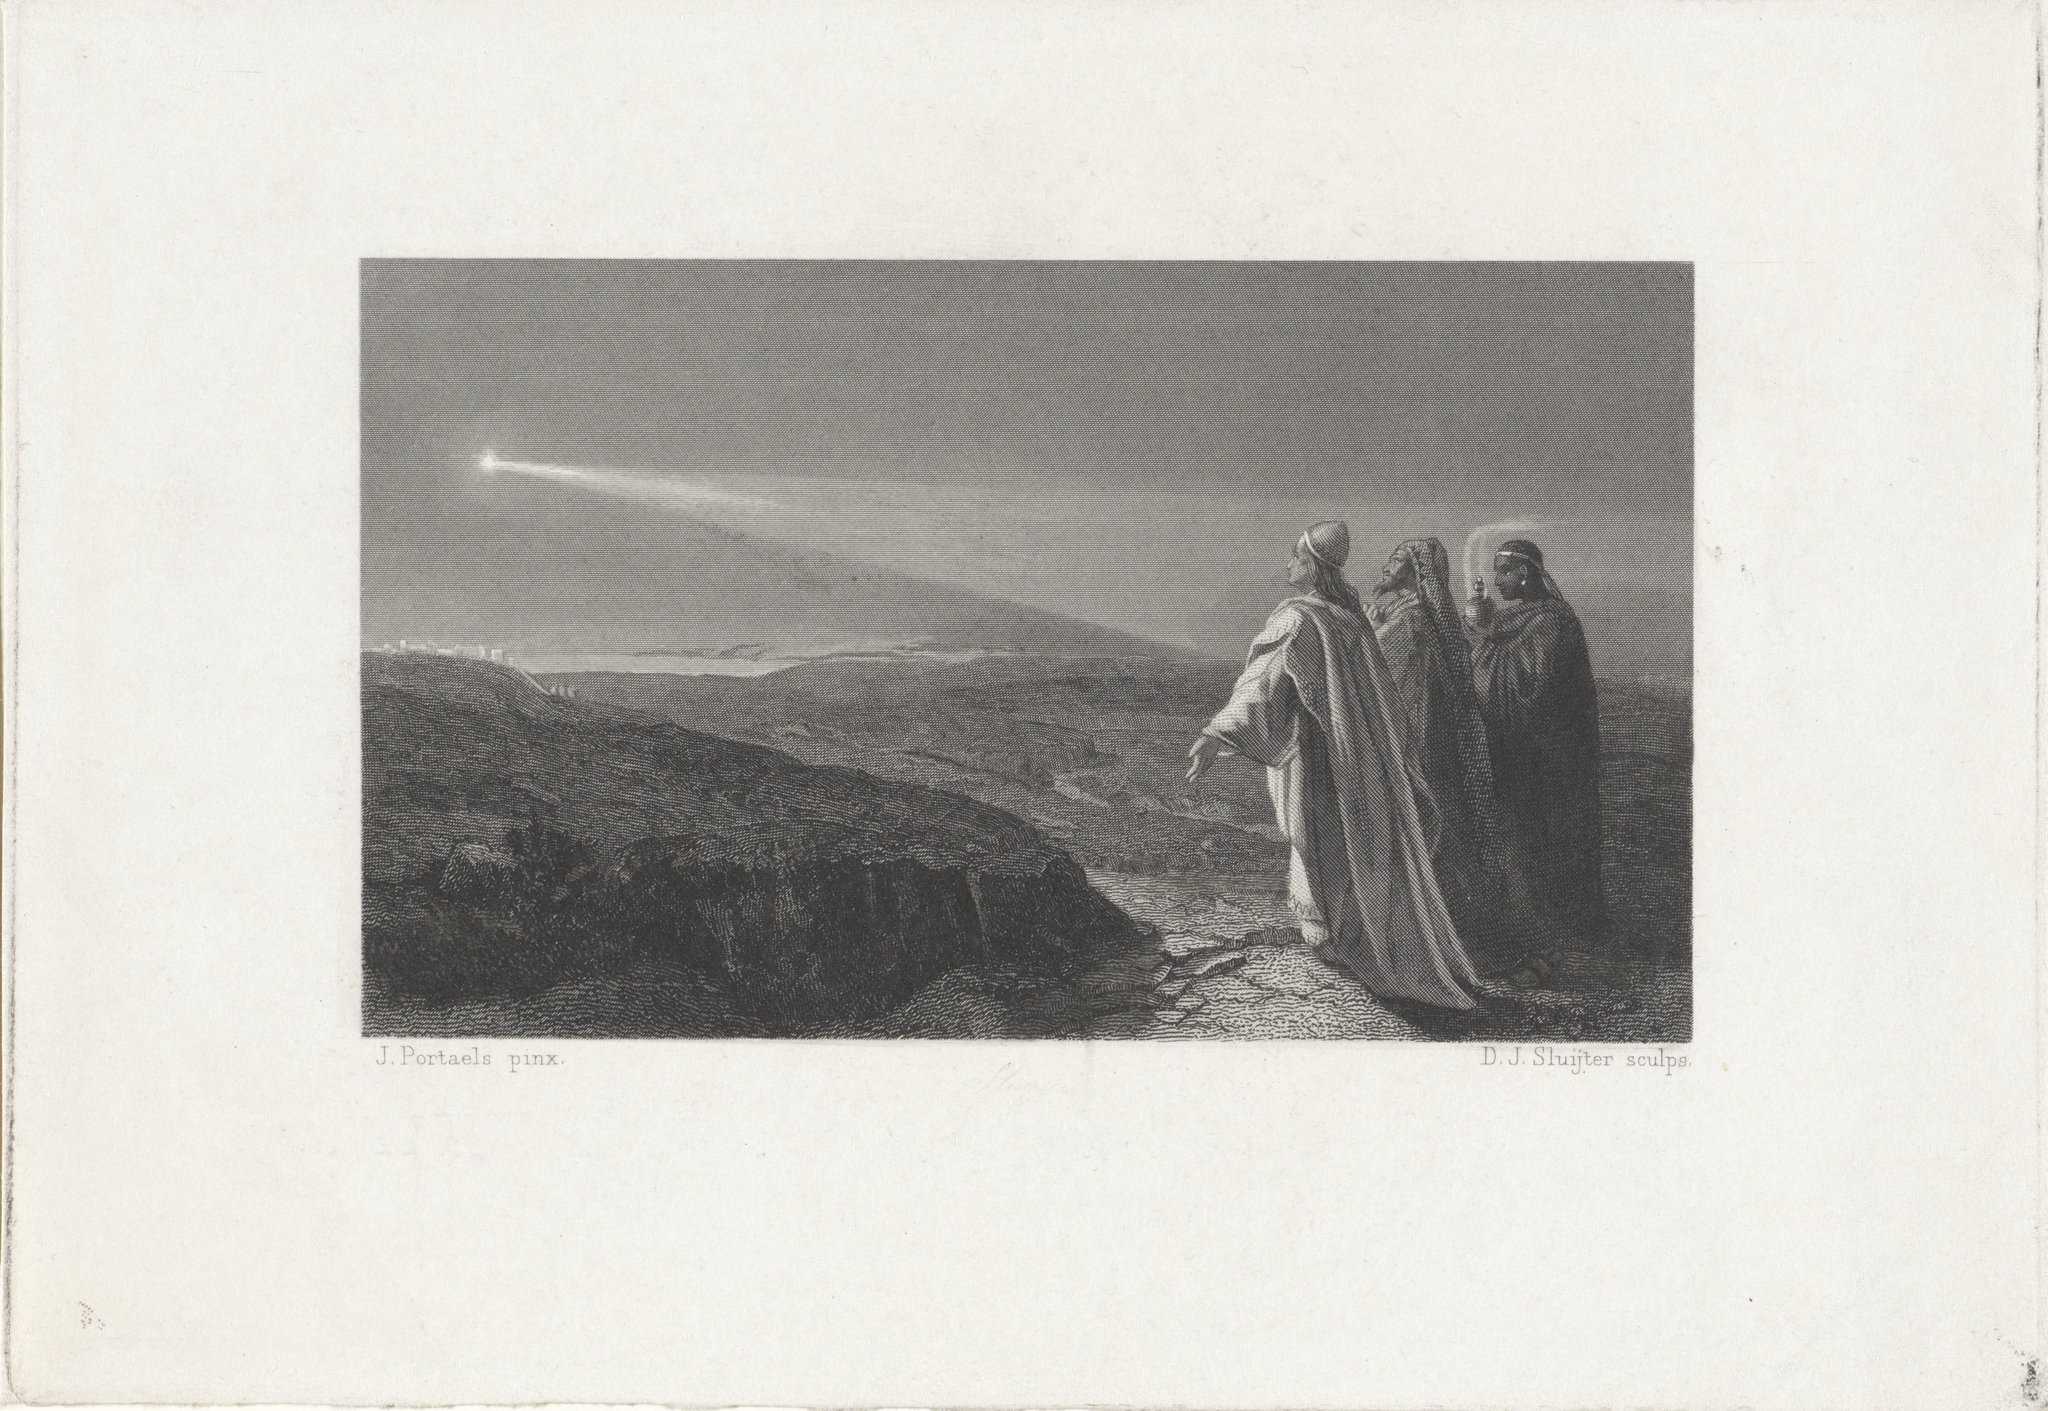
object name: print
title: De drie koningen zien de ster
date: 1826-1886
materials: paper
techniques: engraving, etching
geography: amsterdam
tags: the three wise men see a star and are astonished by its magnitude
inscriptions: collector's mark: Lugt 2228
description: De drie koningen staan op een heuveltop en worden beschenen door het licht van de ster waarnaar ze kijken. Koning Balthasar houdt een wierookvat vast.